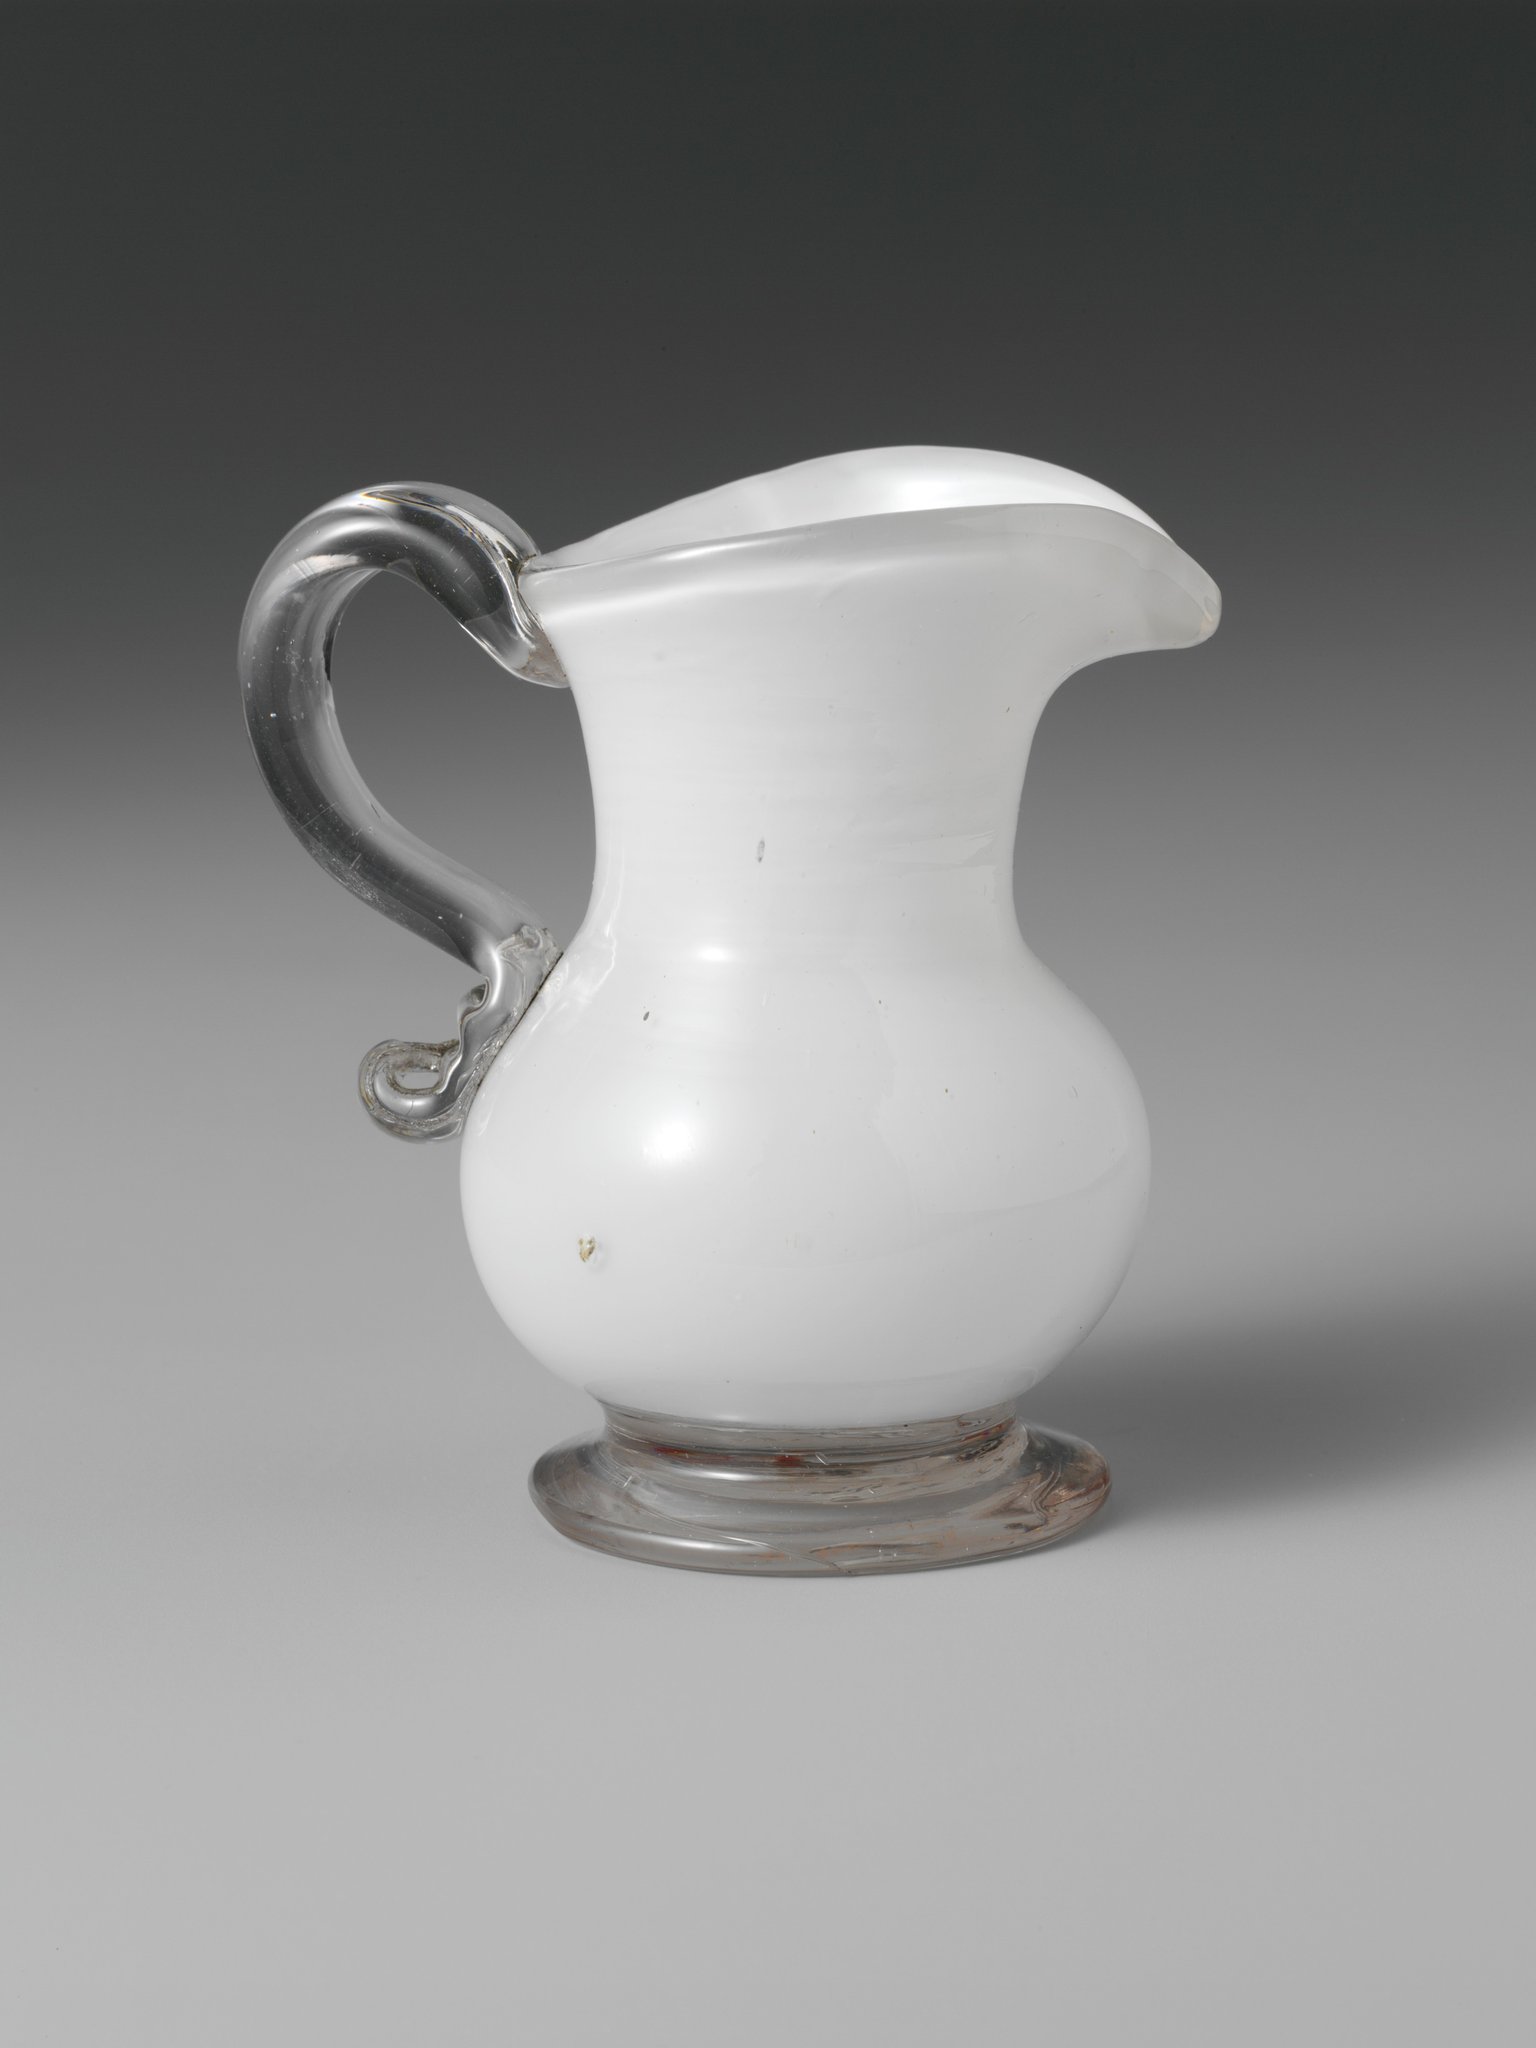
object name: communion flagon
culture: american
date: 1830-1870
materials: glass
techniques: glassblowing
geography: united states